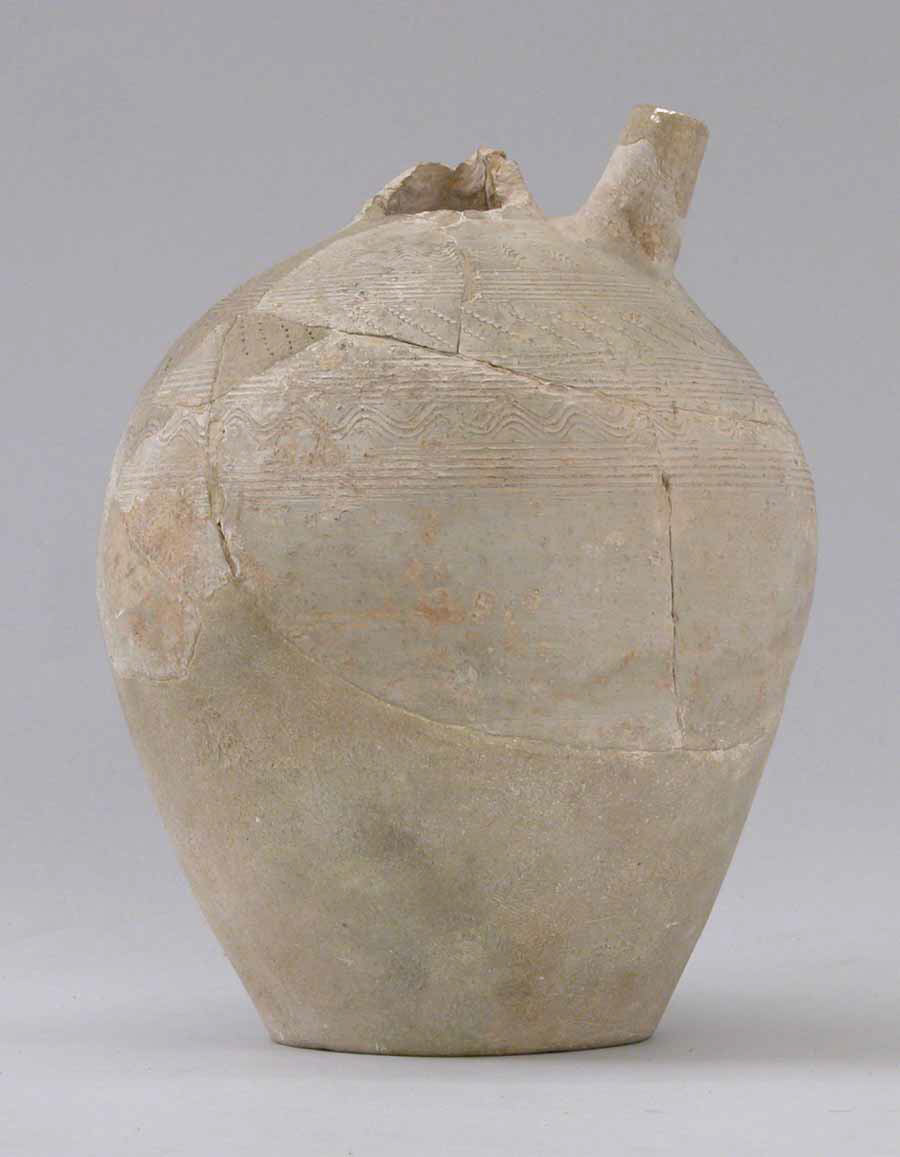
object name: ewer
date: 701-800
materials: earthenware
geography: iran